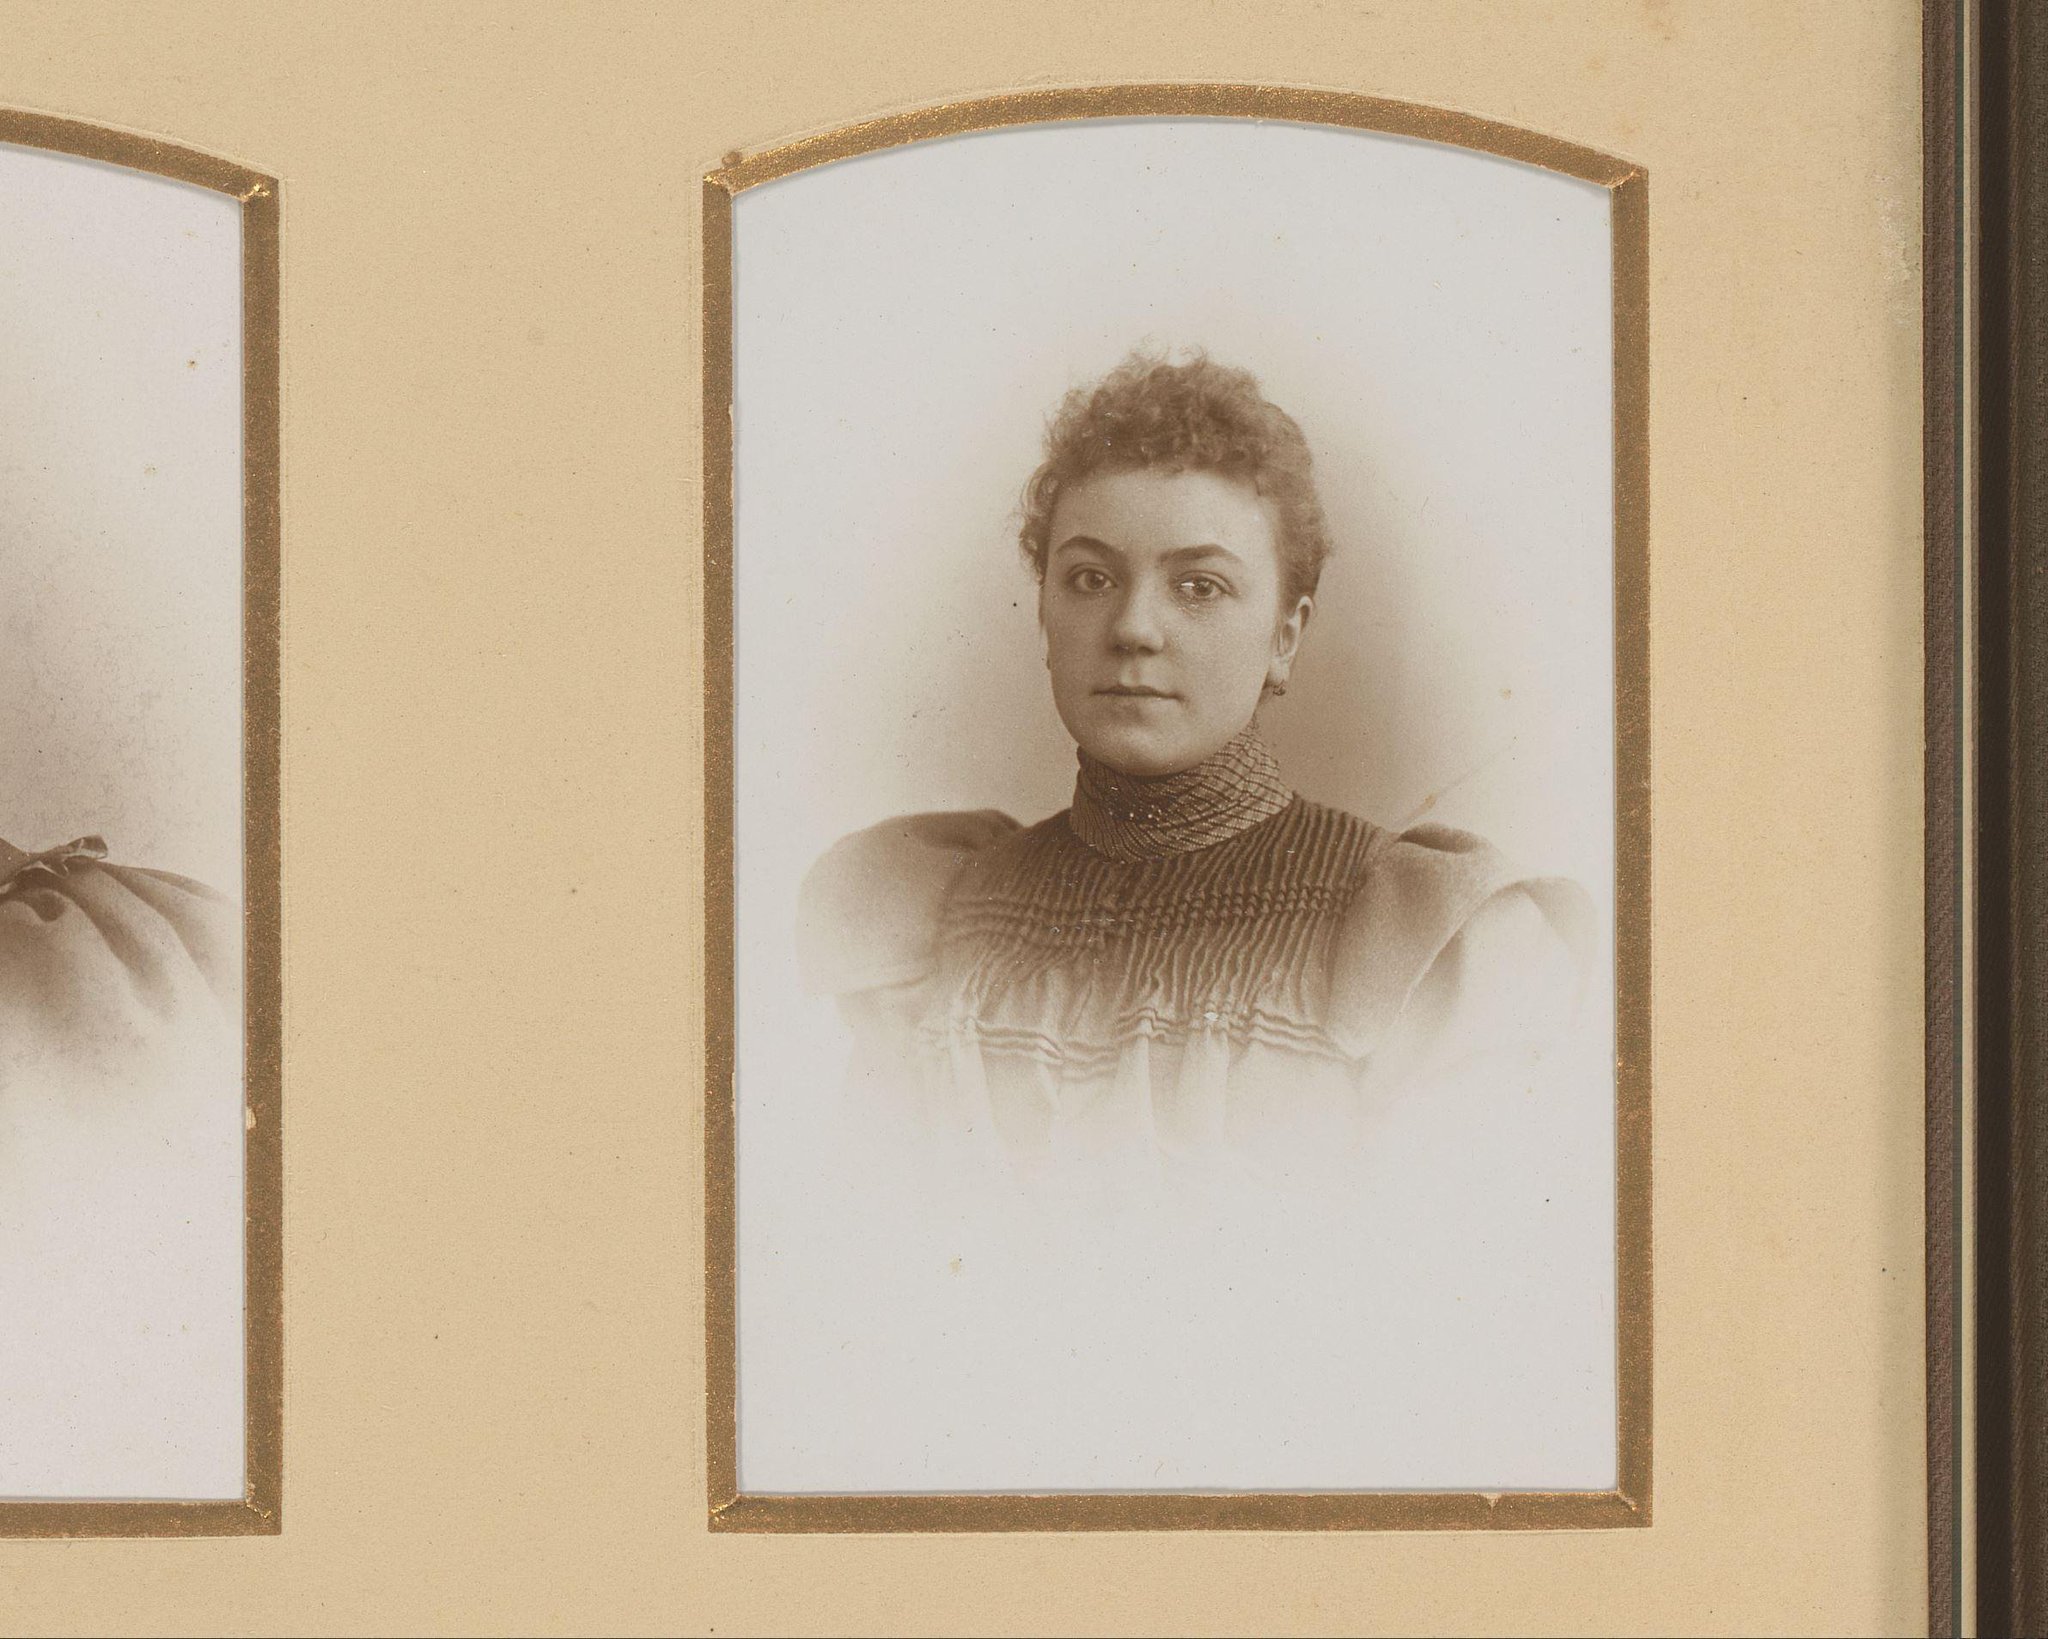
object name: carte de visite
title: Portret van een jonge vrouw in hooggesloten jurk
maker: machiel hendricus laddé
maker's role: fotograaf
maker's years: 1866-1932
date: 1892-1906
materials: cardboard, photographic support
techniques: collodion silver print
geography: amsterdam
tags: historical persons - bb - woman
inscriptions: inscription: ‘Fotografie/ Artistique/ M. H. Laddé/ Nieuwendijk 57-59/ boven de Firma MERKELBACH & Co./ Het Cliché wordt voor verdere bestellingen bewaard.’